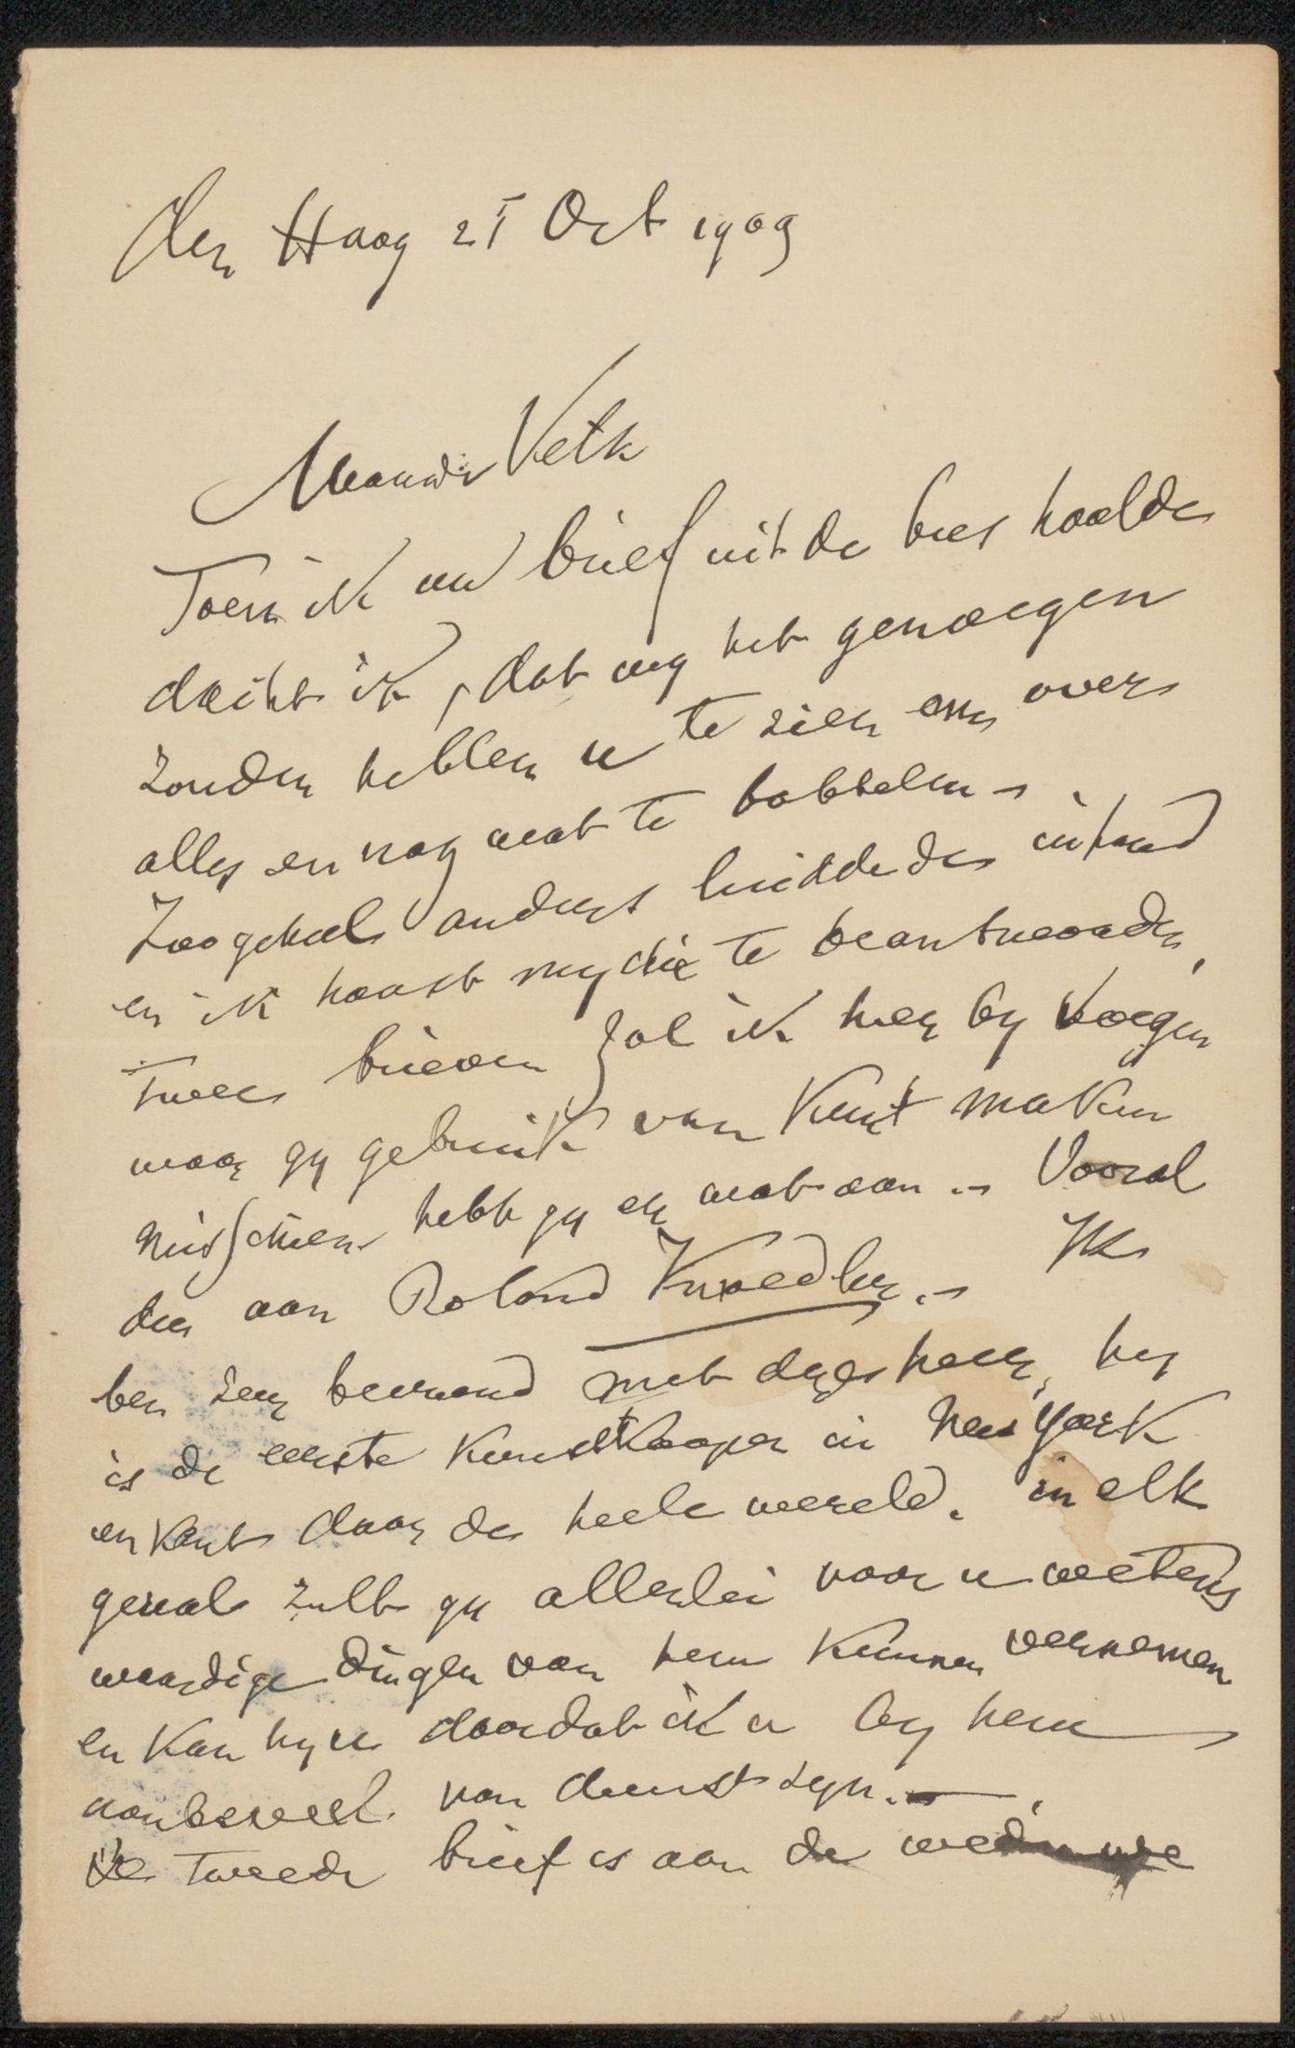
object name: letter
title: Brief aan Jan Veth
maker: jozef israëls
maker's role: draughtsman, painter, print maker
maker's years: 1824-1911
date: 1909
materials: ink, paper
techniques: pen, writing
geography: the hague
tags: dordrecht, amsterdam, painter, print maker, draughtsman, designer, jan veth, aby warburg, art trade, art shop, painting (including book-illumination, miniature-painting), new york (city)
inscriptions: collector's mark: ‘RPK’, watermark